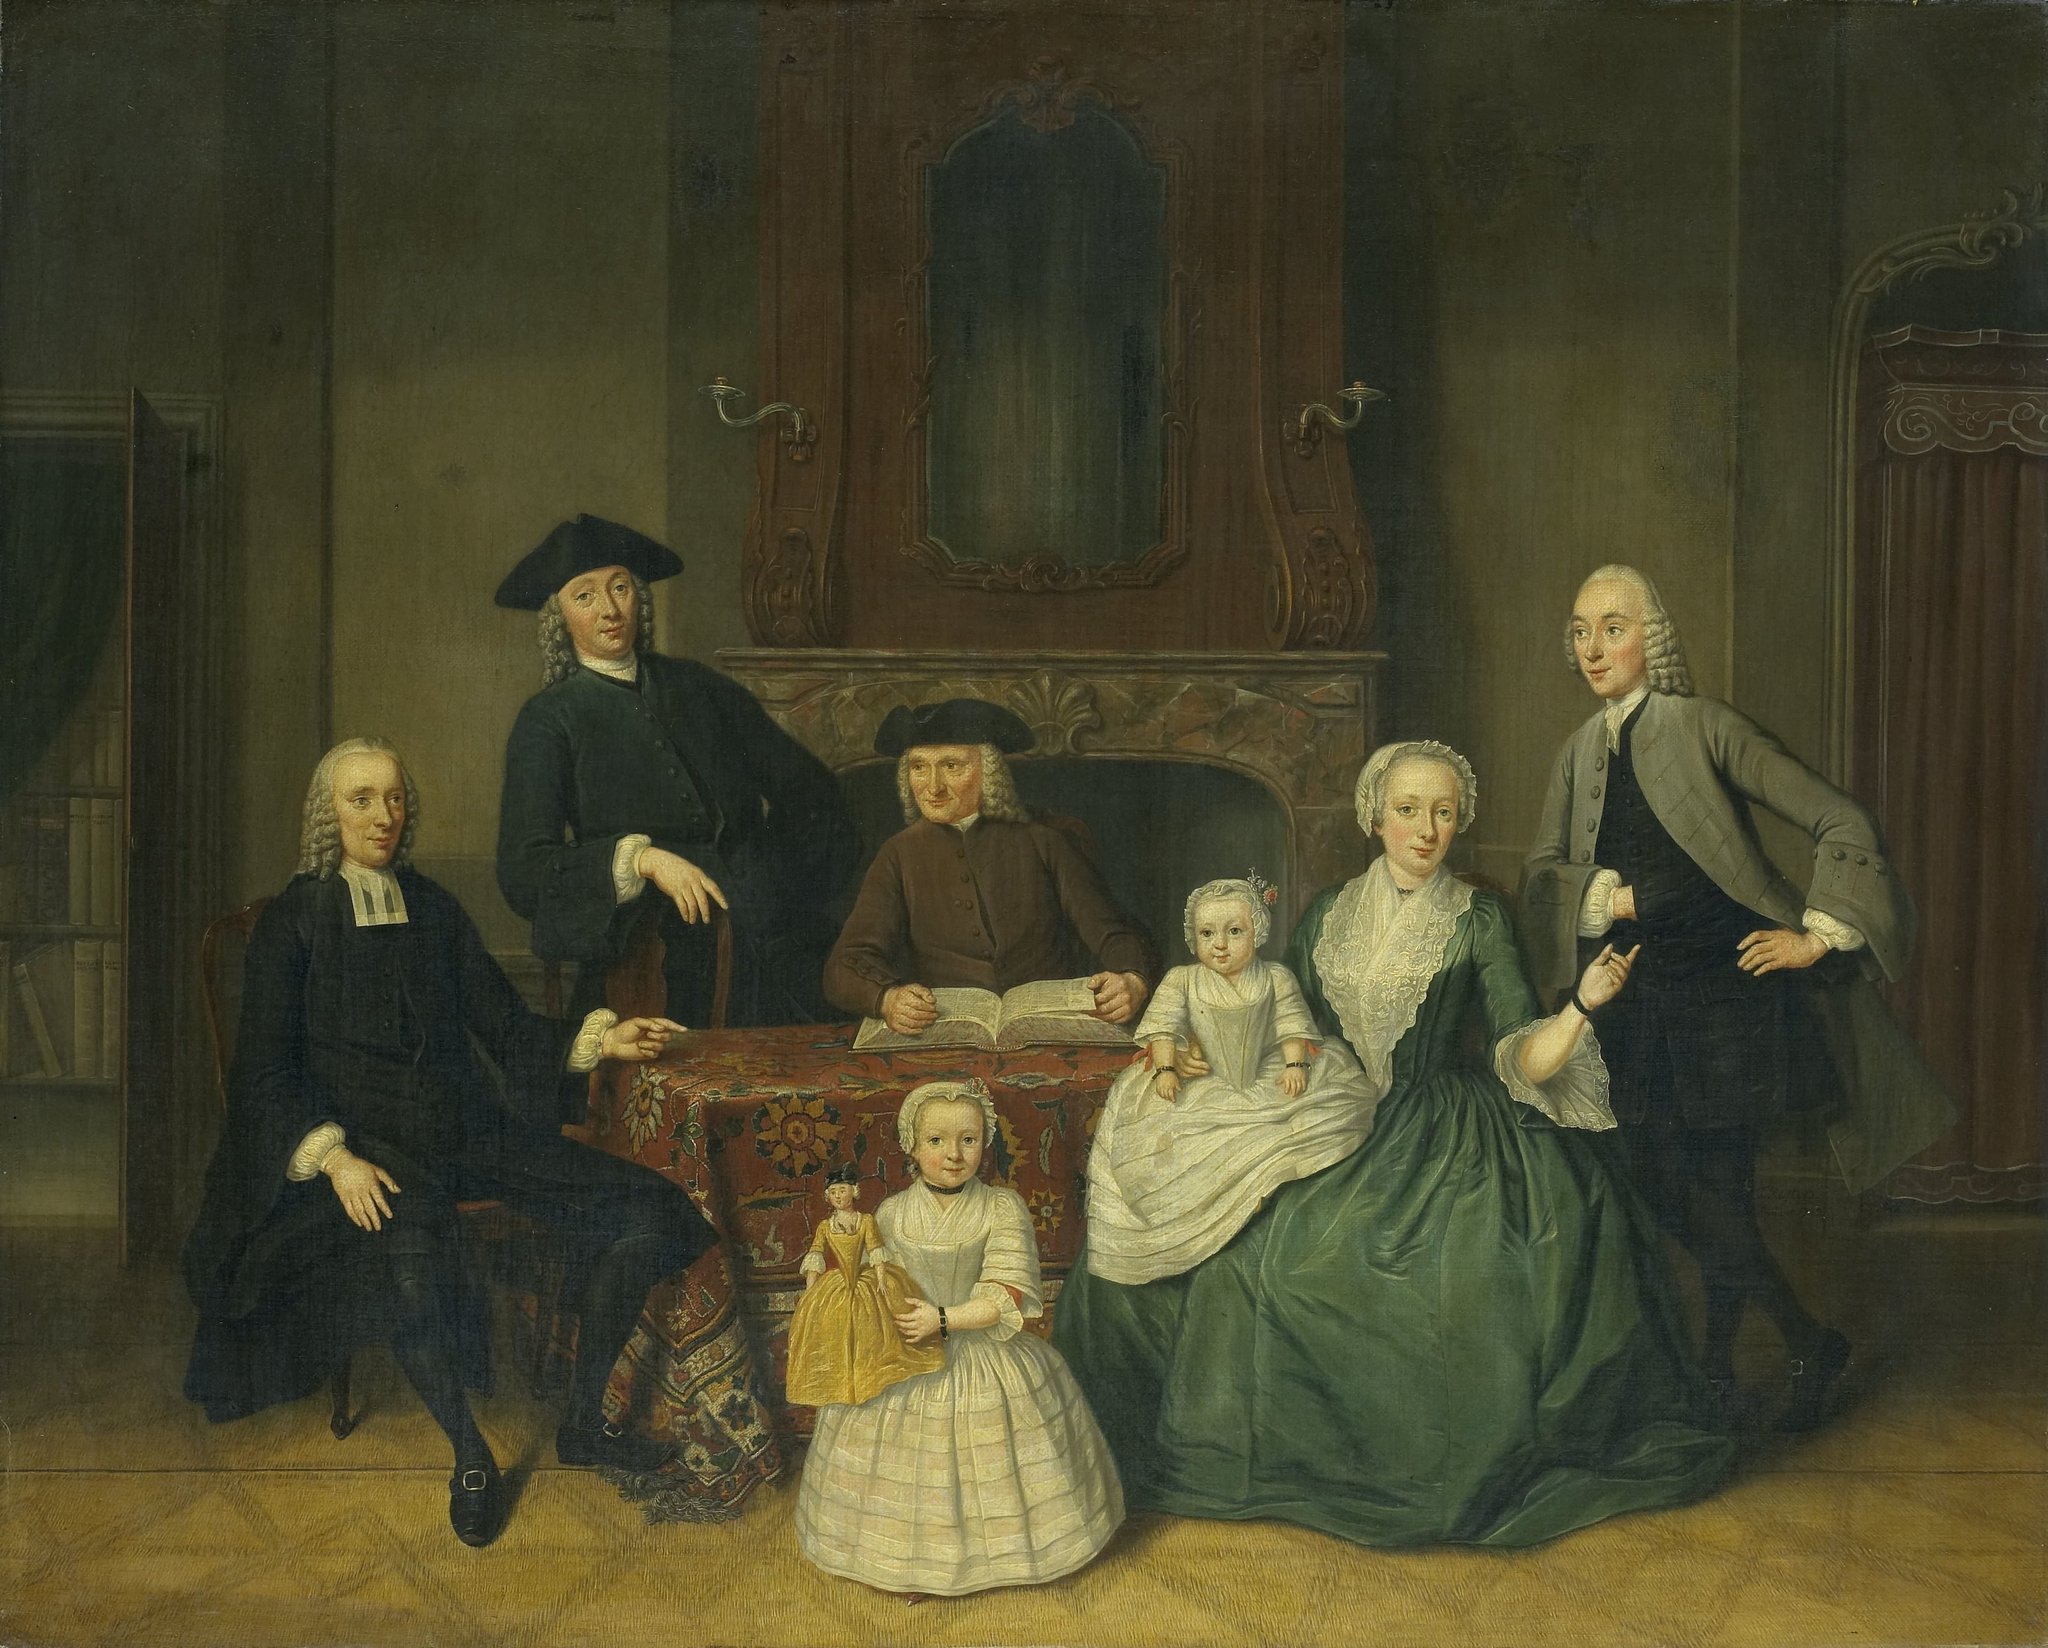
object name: painting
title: Portrait of the Brak Family, Amsterdam Mennonites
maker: tibout regters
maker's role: draughtsman, painter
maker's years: 1710-1768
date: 1752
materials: canvas, oil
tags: historical persons - bb - woman, historical persons, family, relationship, descent, communal rooms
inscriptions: signature and date: ‘T. Regters pinxit 1752’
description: Familieportret van de Amsterdamse doopsgezinde familie Brak in een interieur zittend rond een tafel voor een schoorsteenmantel. Van links naar rechts: dominee Jan Brak (1717-61), zijn broer Pieter Brak (ca. 1714-na 1778), zijn vader Harmen Brak (overl. 1768), zijn schoonzuster Margaretha Hasselaar (1726-80/83) met haar echtgenoot Cornelis Brak (1724-82). Staande op de voorgrond is hun oudste dochter met een pop, Margaretha (geb. 1752) zit op haar moeders schoot. Links een doorkijk naar de bibliotheek.